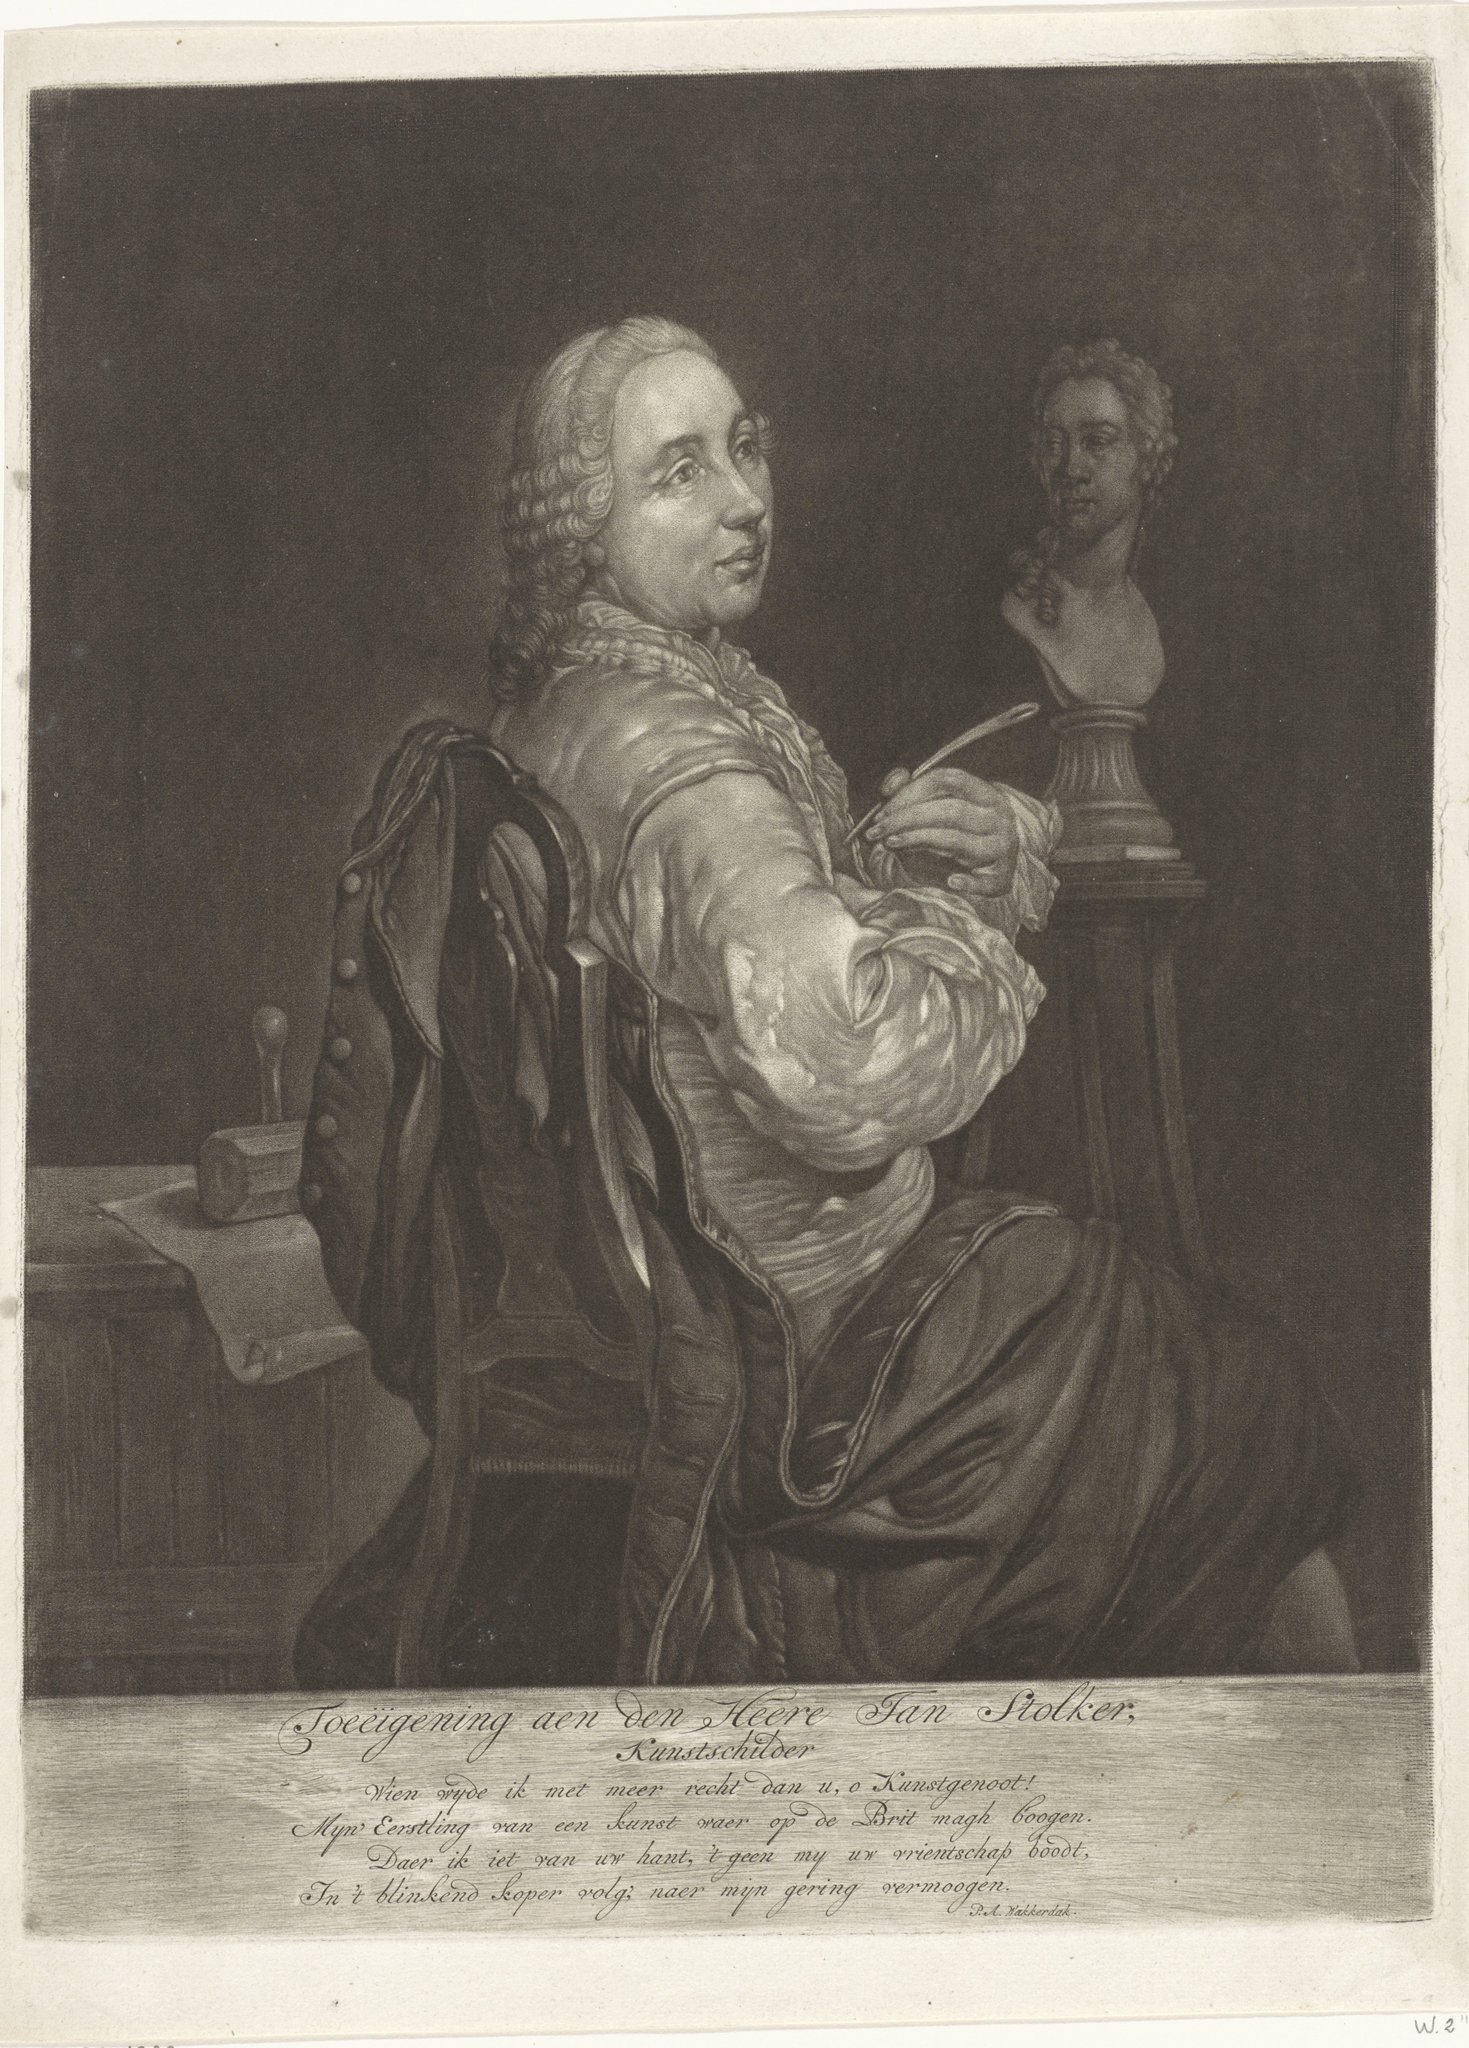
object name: print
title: Portret van Willem Dubbelens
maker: pieter anthony wakkerdak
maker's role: print maker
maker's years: 1729-1774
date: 1740-1774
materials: paper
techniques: mezzotint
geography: delft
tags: amsterdam, painter, print maker, draughtsman, jan stolker, sculptor at work, piece of sculpture, reproduction of a piece of sculpture, wood carver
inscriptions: collector's mark: Lugt 2760, collector's mark: Lugt 2228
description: De houtsnijder Willem Dubbelens zit in een stoel voor een buste. In zijn hand heeft hij een instrument.